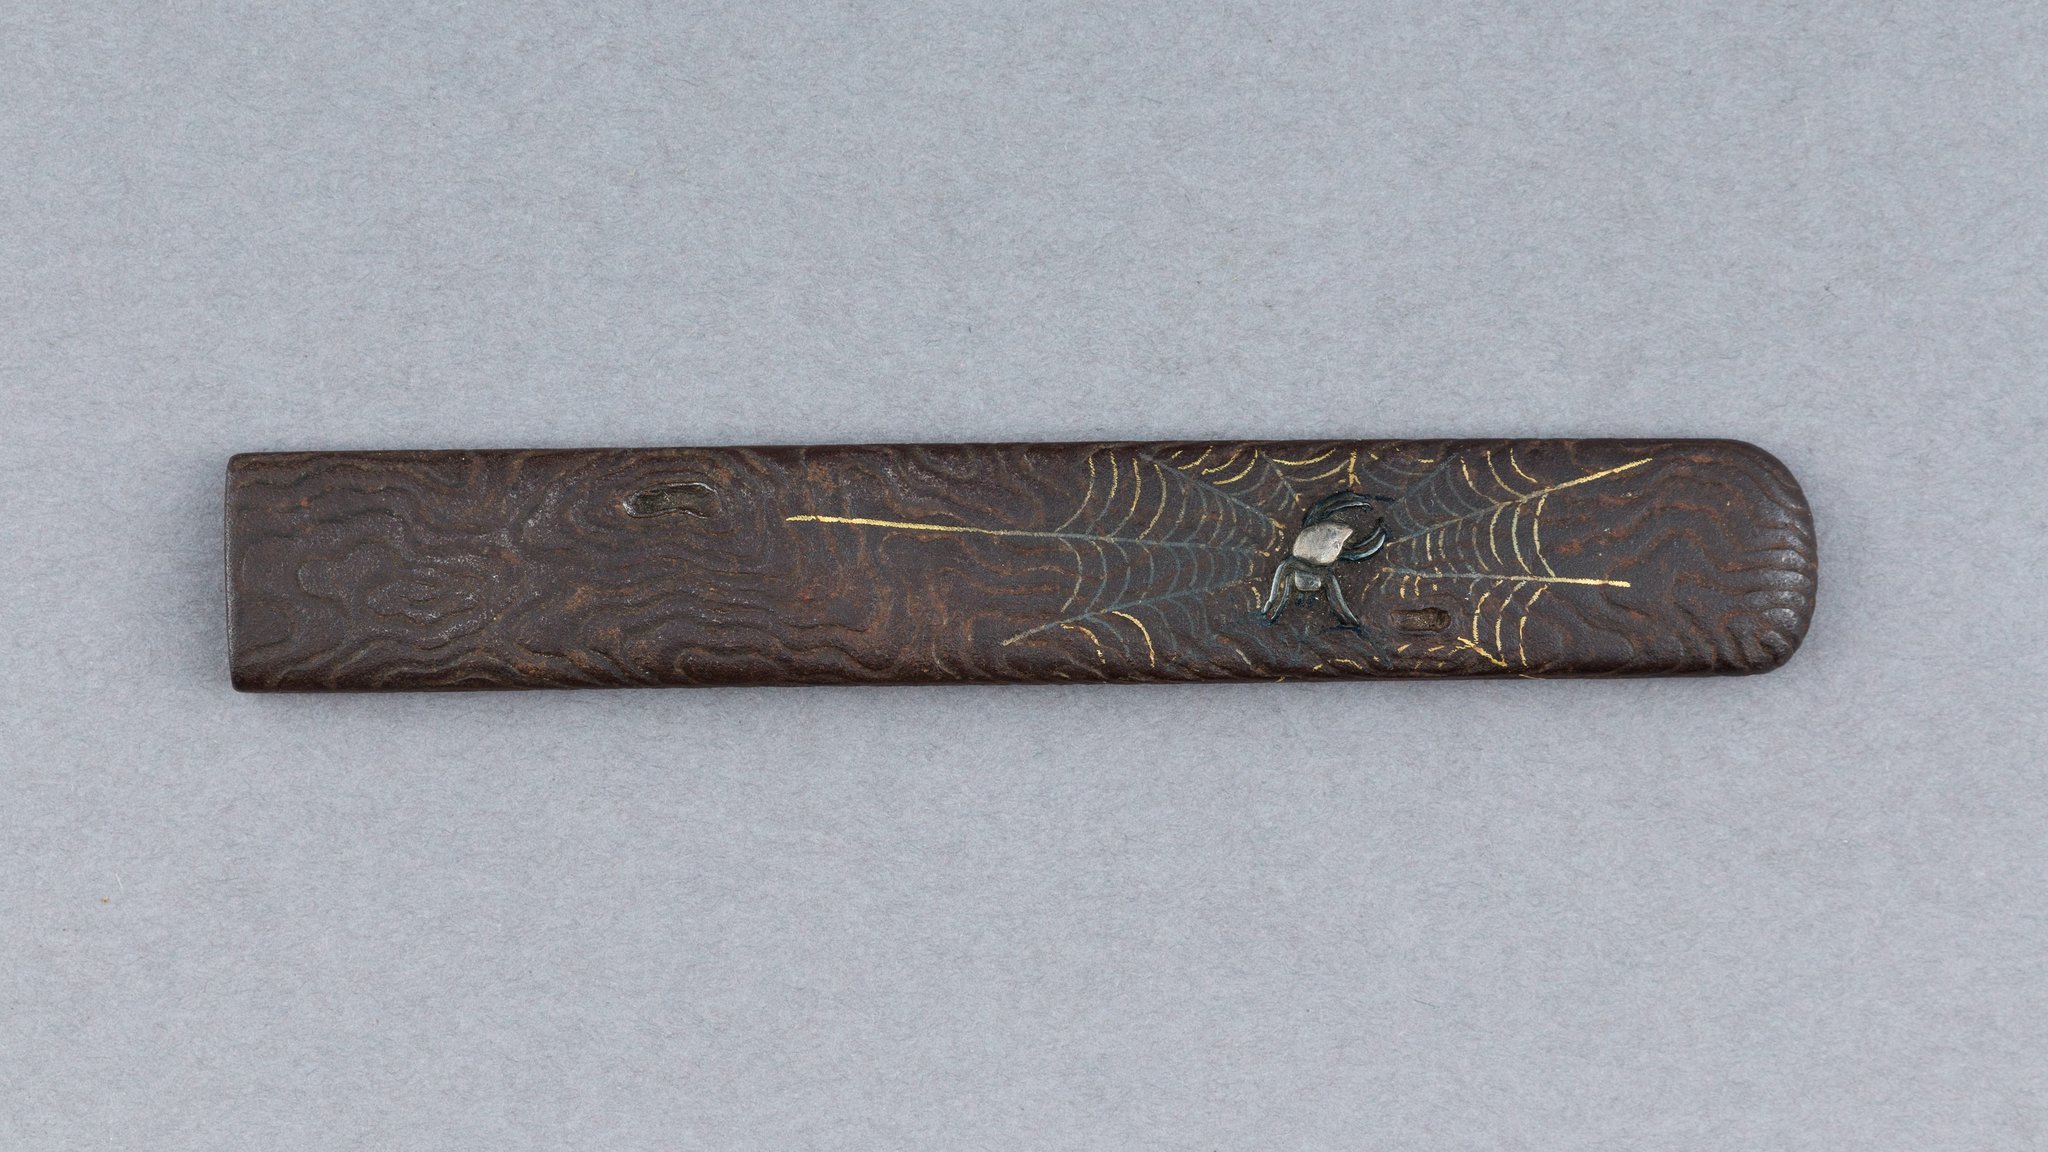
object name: knife handle kozuka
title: Knife Handle (Kozuka)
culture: japanese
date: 1615-1868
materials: gold, iron, silver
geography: japan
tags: spiders